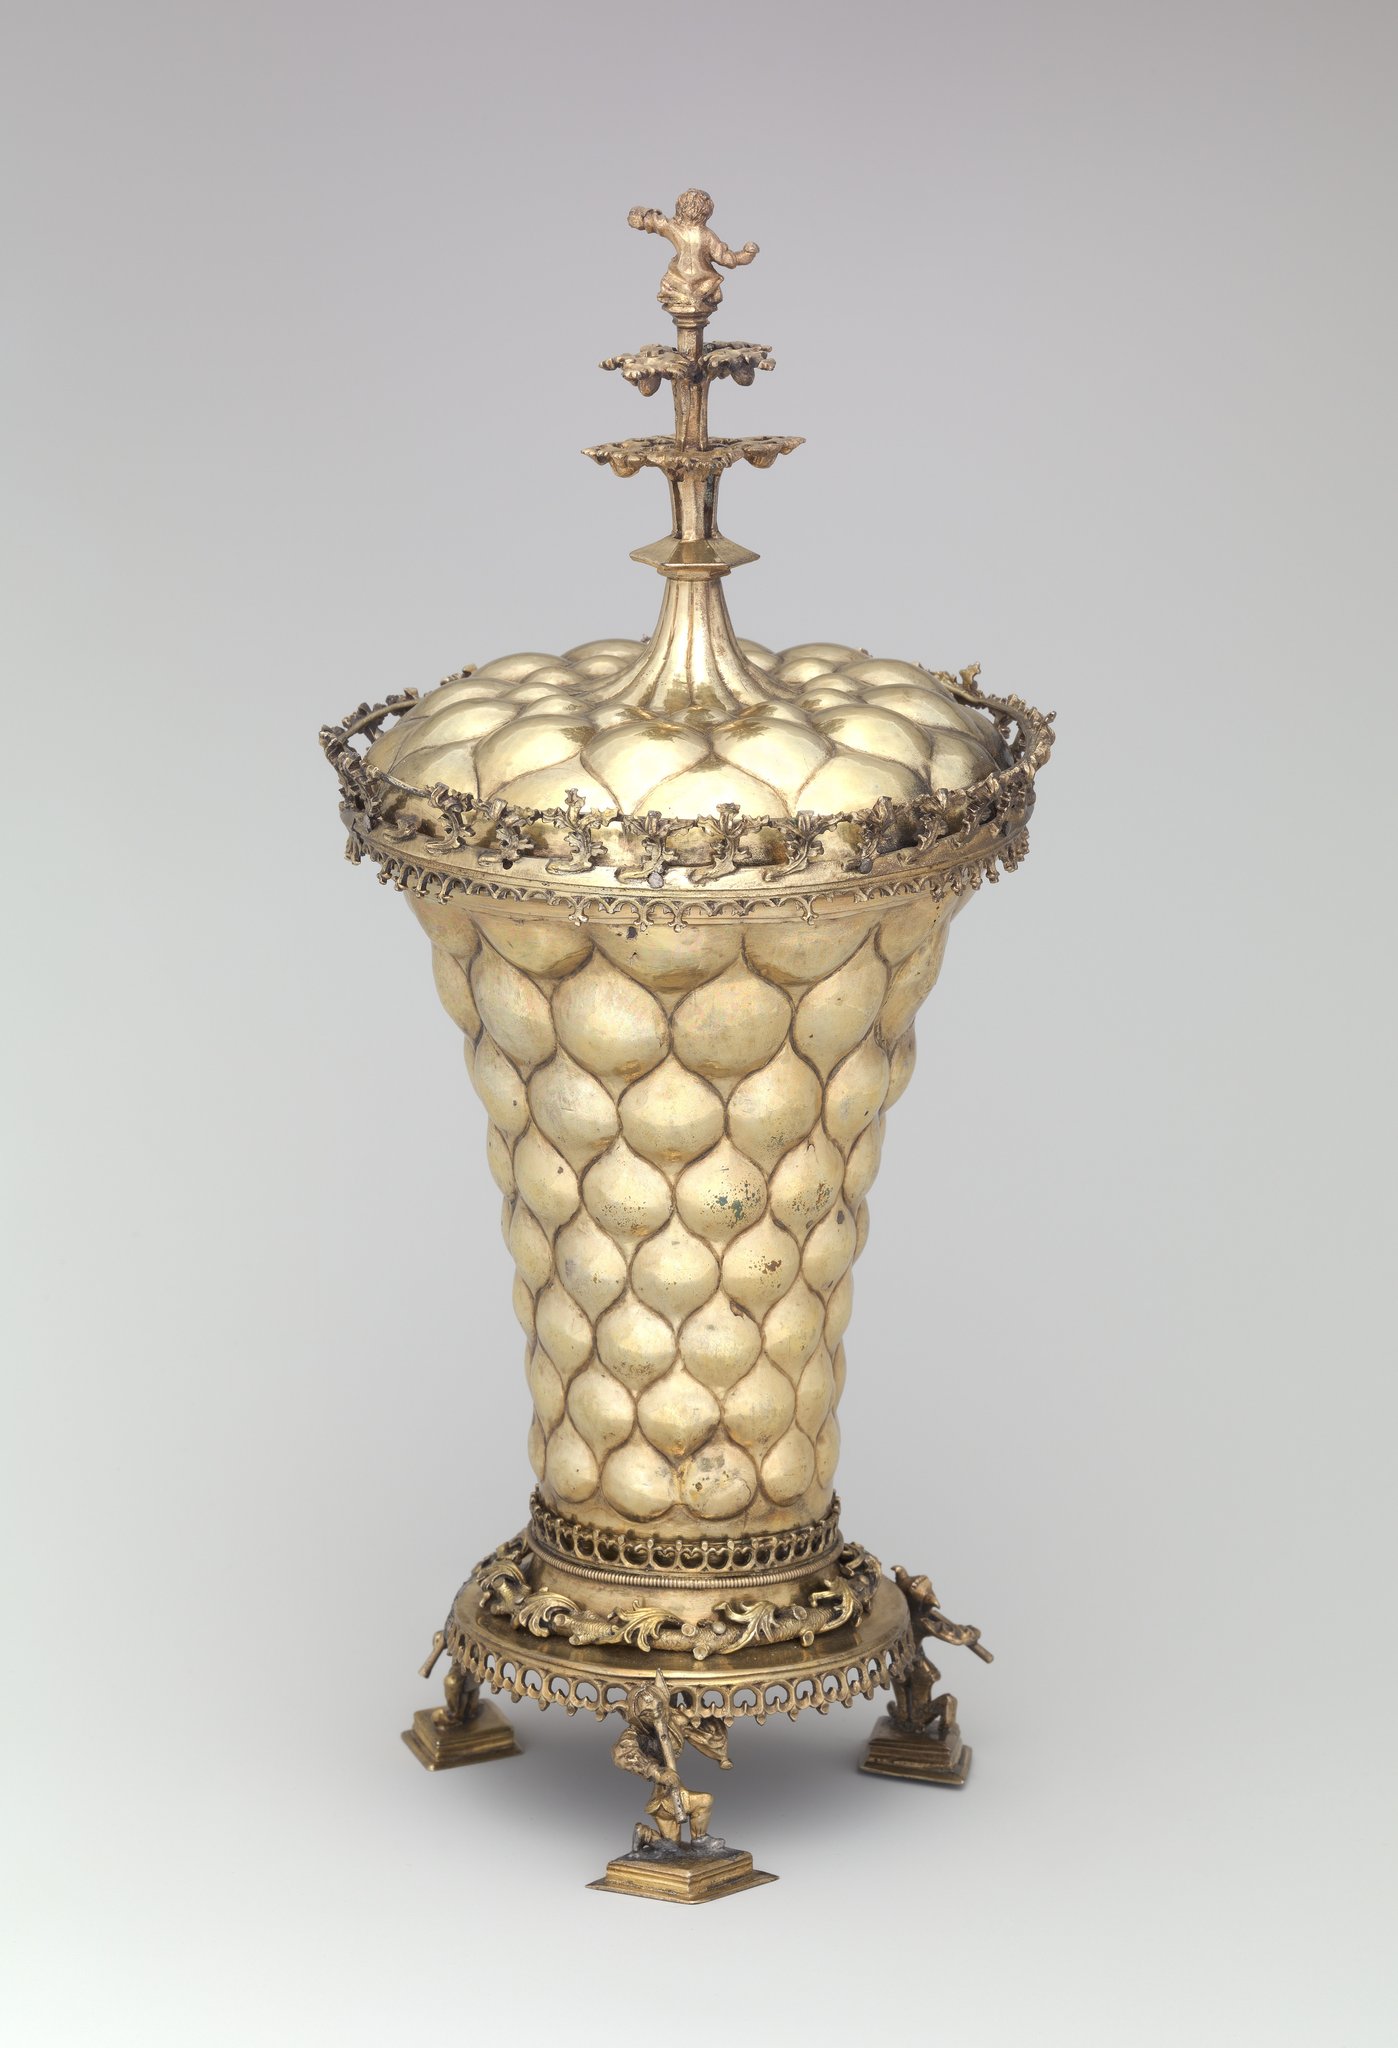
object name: beaker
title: Covered Beaker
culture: german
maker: hans greiff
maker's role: artist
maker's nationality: german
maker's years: 1470-1516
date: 1470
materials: gilt, silver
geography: germany